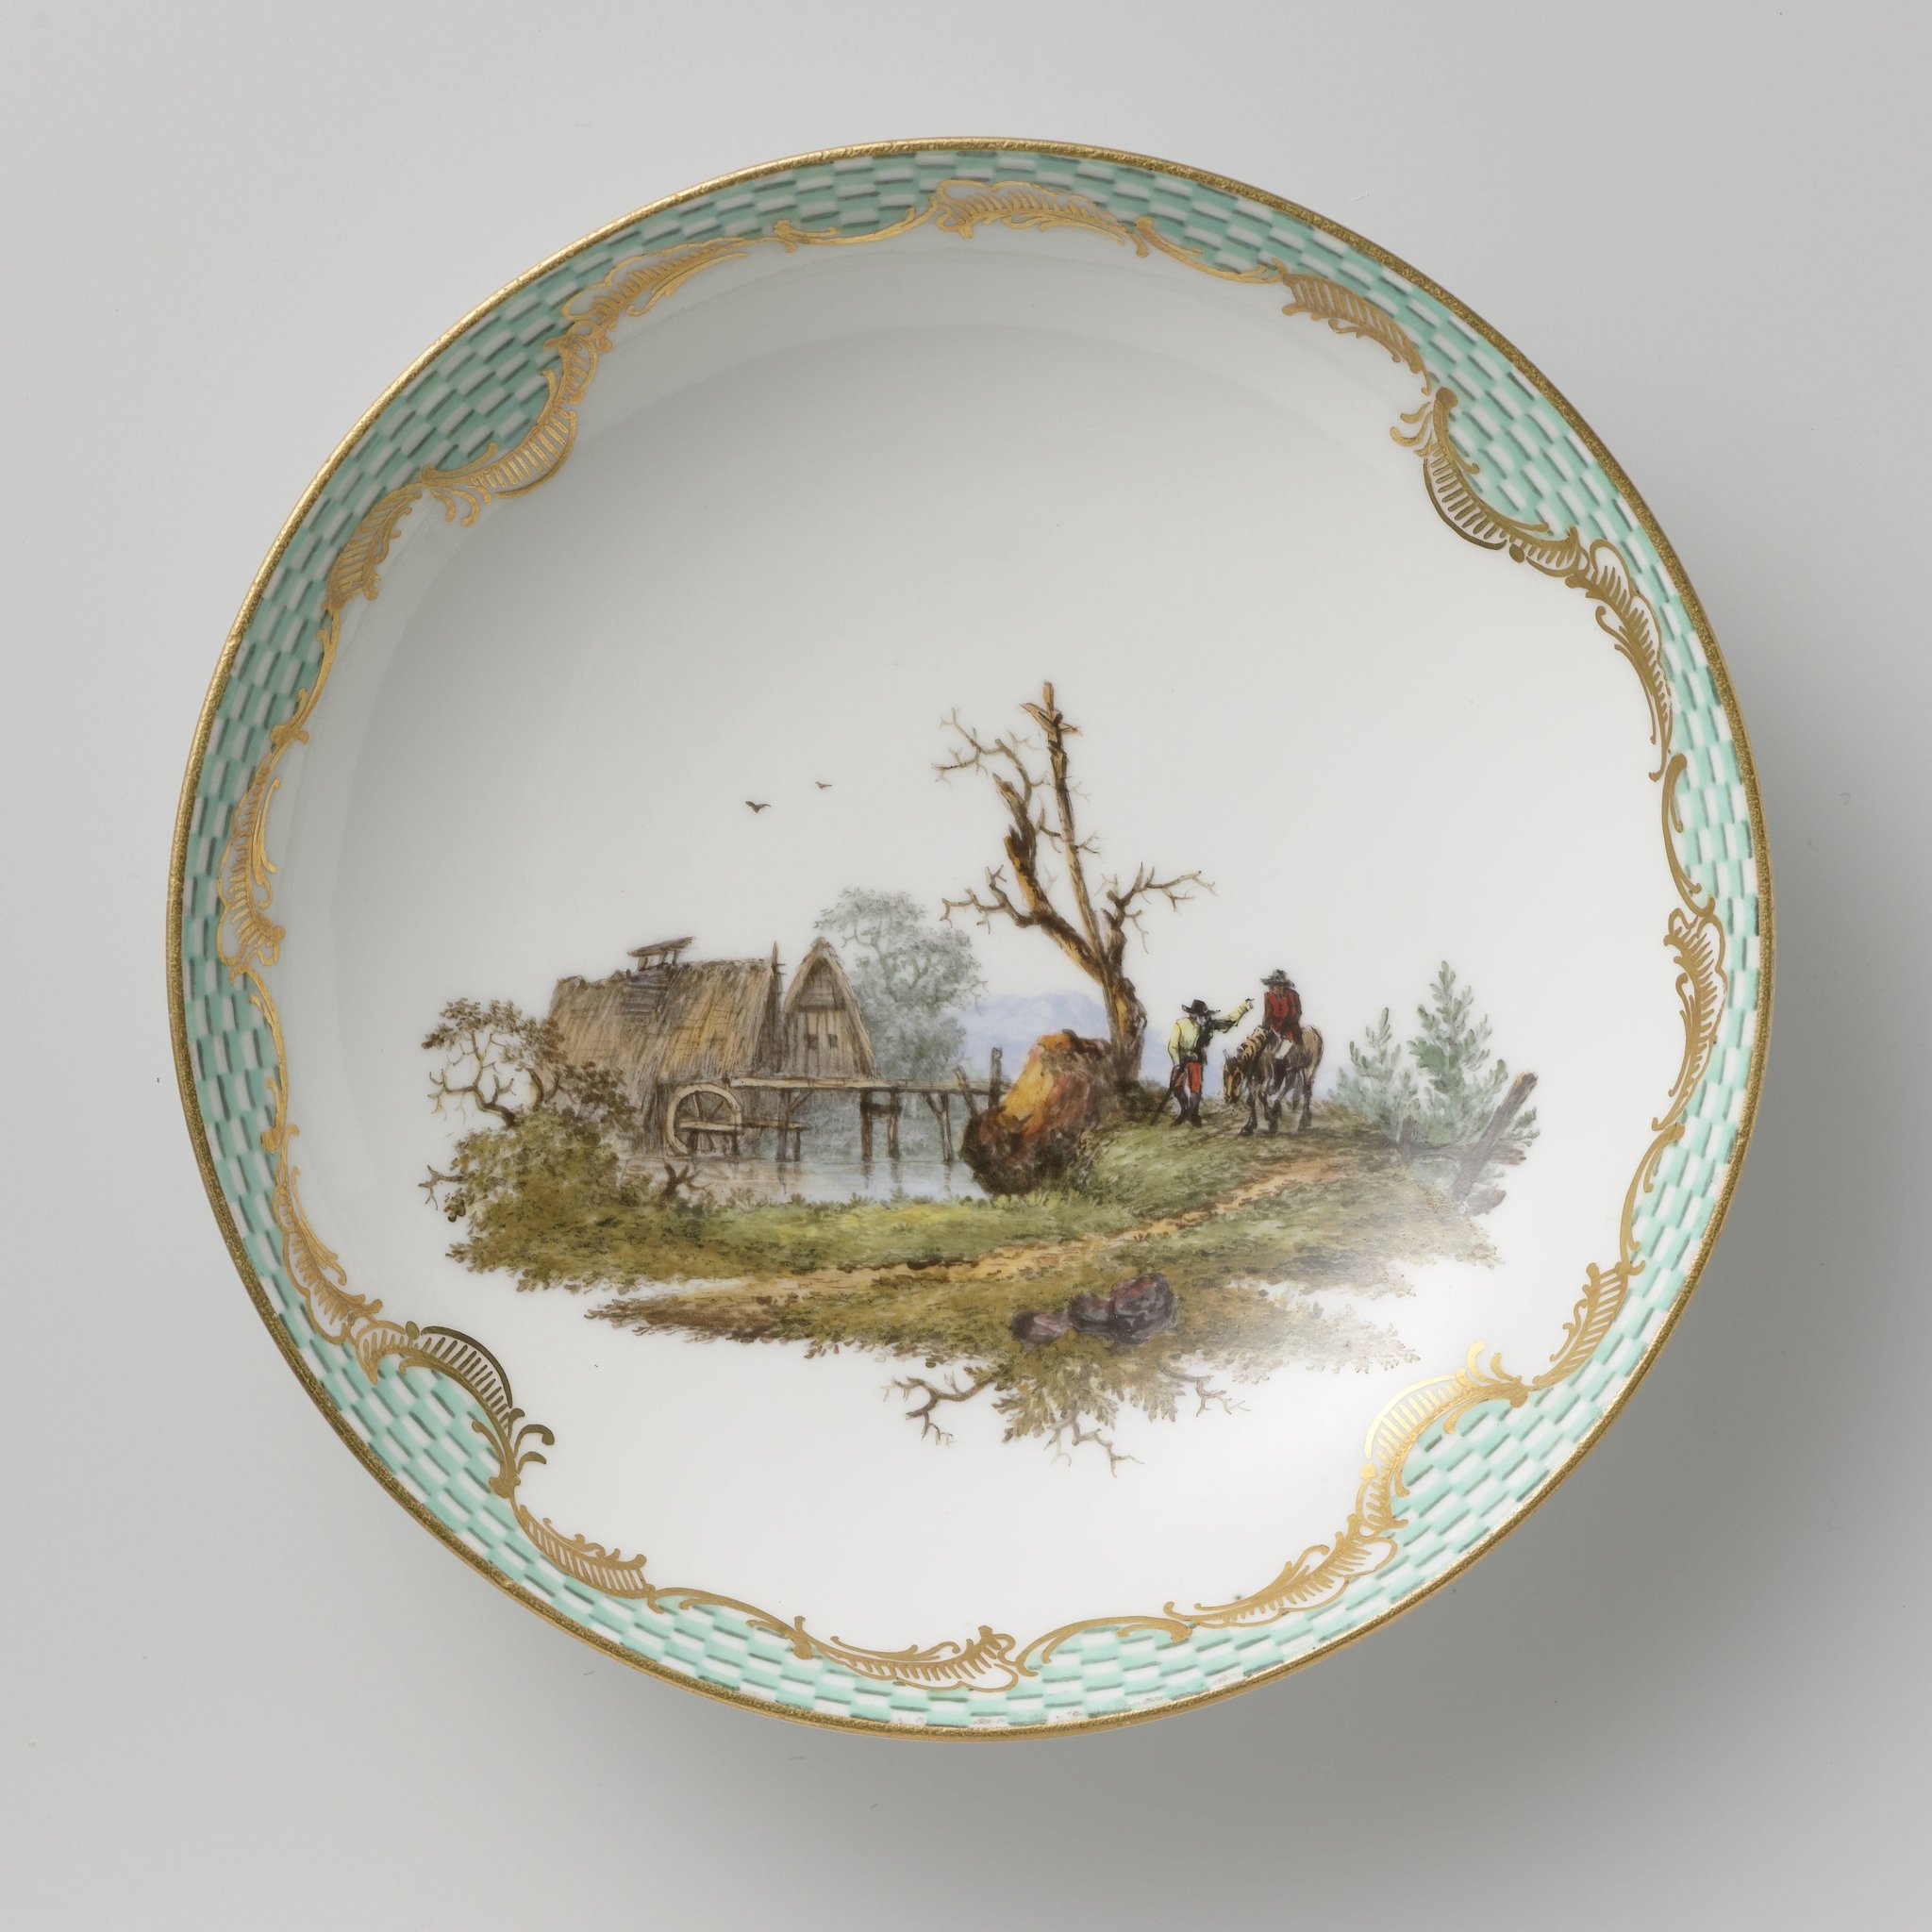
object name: platter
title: Schotel, veelkleurig beschilderd met een landschap met figuren.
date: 1777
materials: porcelain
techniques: painted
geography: meissen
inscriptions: mold mark: ‘5’, factory mark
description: Ronde schotel van beschilderd porselein. De schotel is beschilderd met landschappen waarin figuren en langs de rand een brede strook groen vlechtwerk. De schotel is gemerkt.